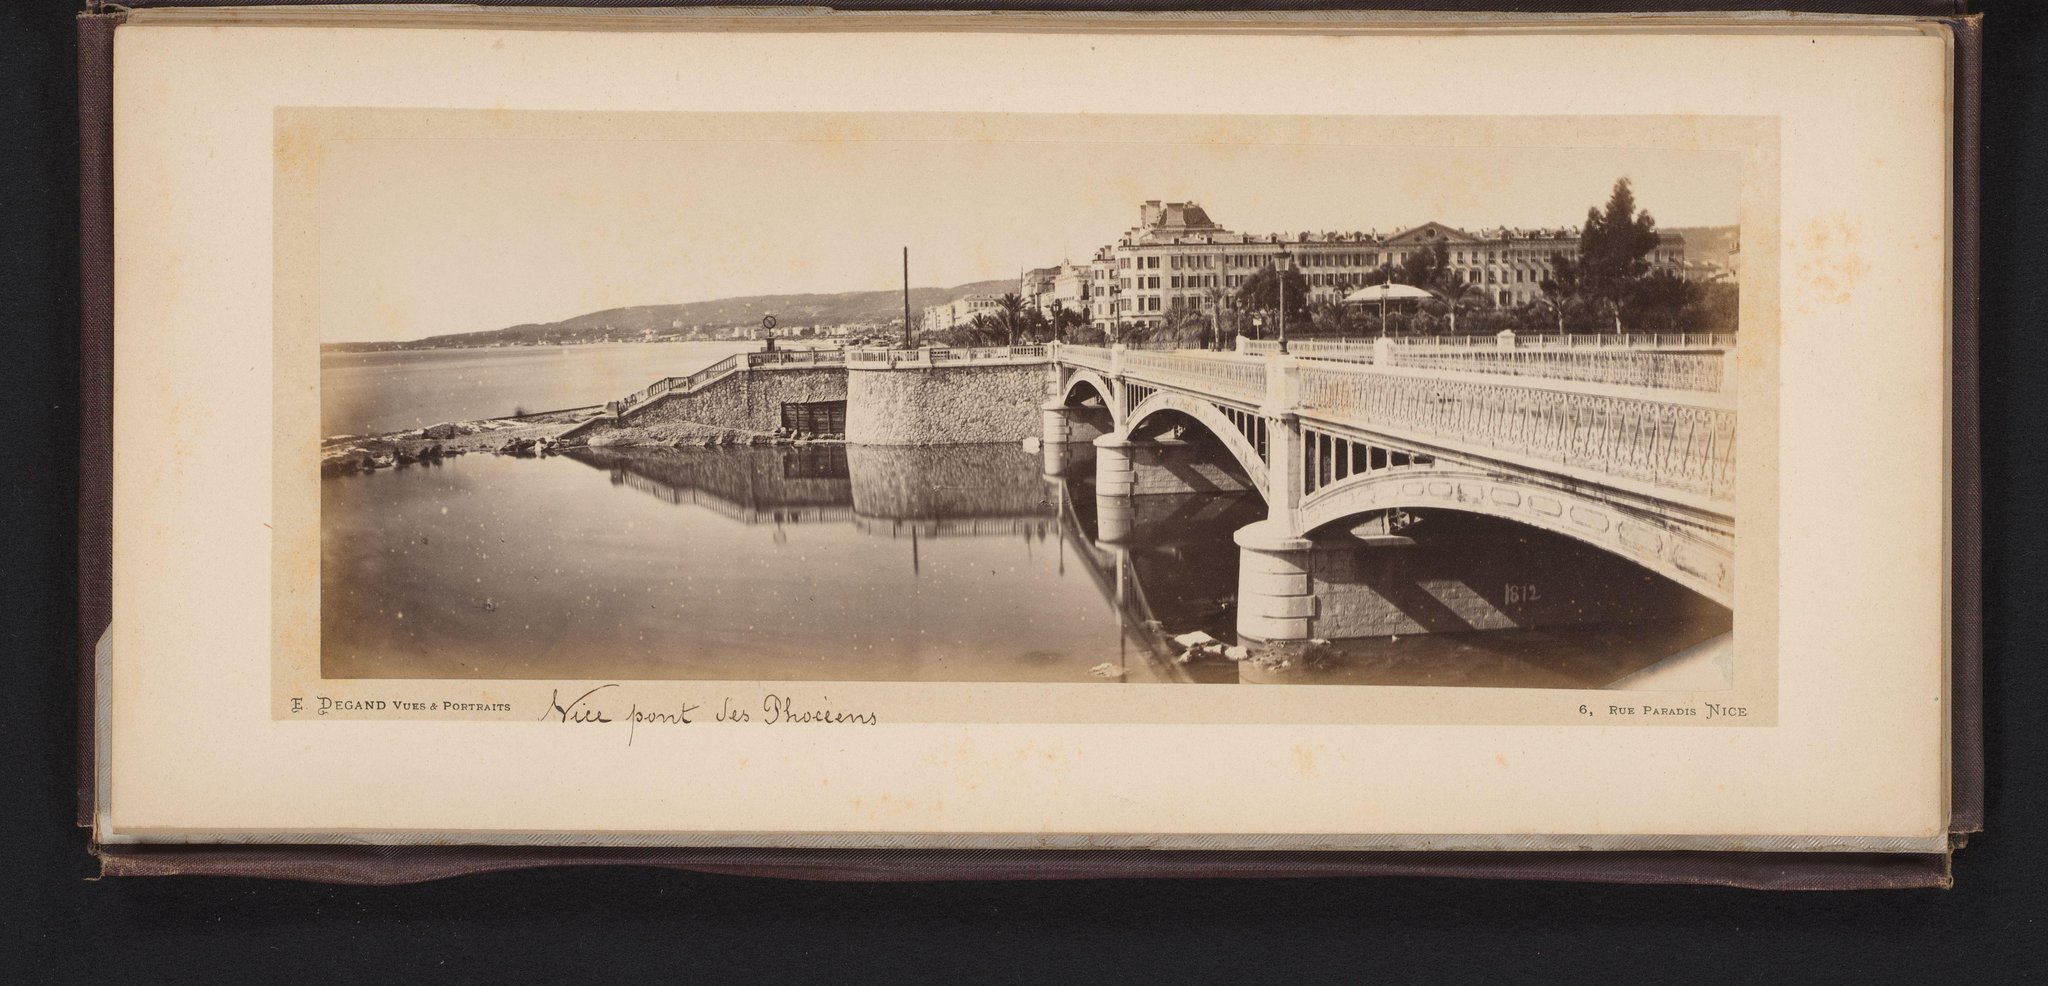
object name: blad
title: Gezicht op Pont des Anges te Nice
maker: eugène degand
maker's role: painter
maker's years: 1829-1911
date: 1872-1874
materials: cardboard, photographic support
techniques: albumen print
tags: landscapes with waters, waterscapes, seascapes (in the temperate zone), bridge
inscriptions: inscription: ‘E. Degand Vues&Portraits 6, Rue Paradis Nice’, annotation: ‘Nice, pont des Bho’